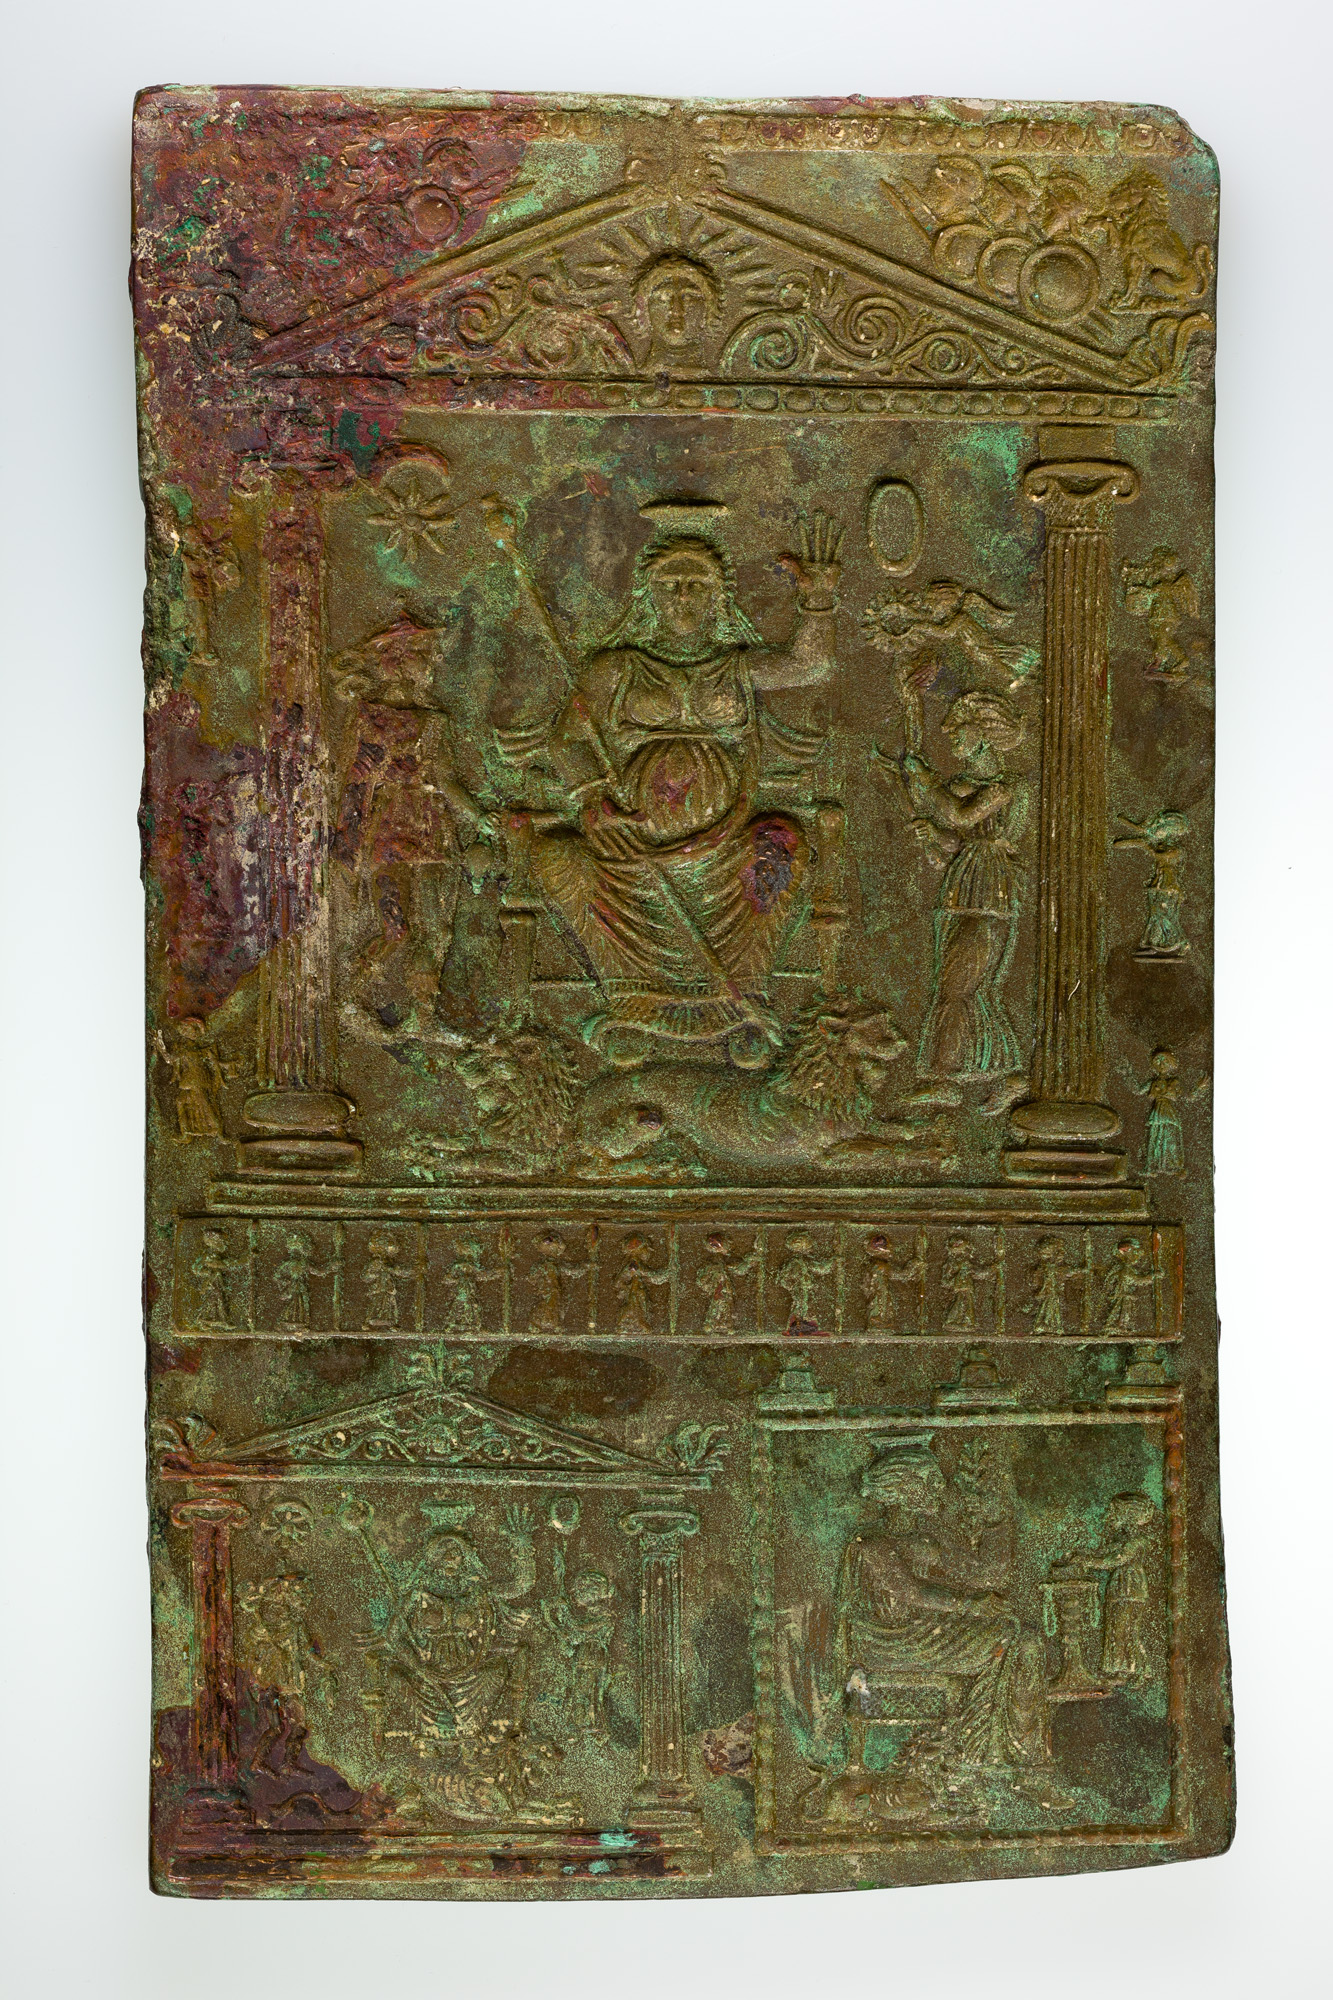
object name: die, goldsmith's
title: Goldsmith's die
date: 201-300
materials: bronze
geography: egypt or italy or turkey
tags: human figures,lions,goddess